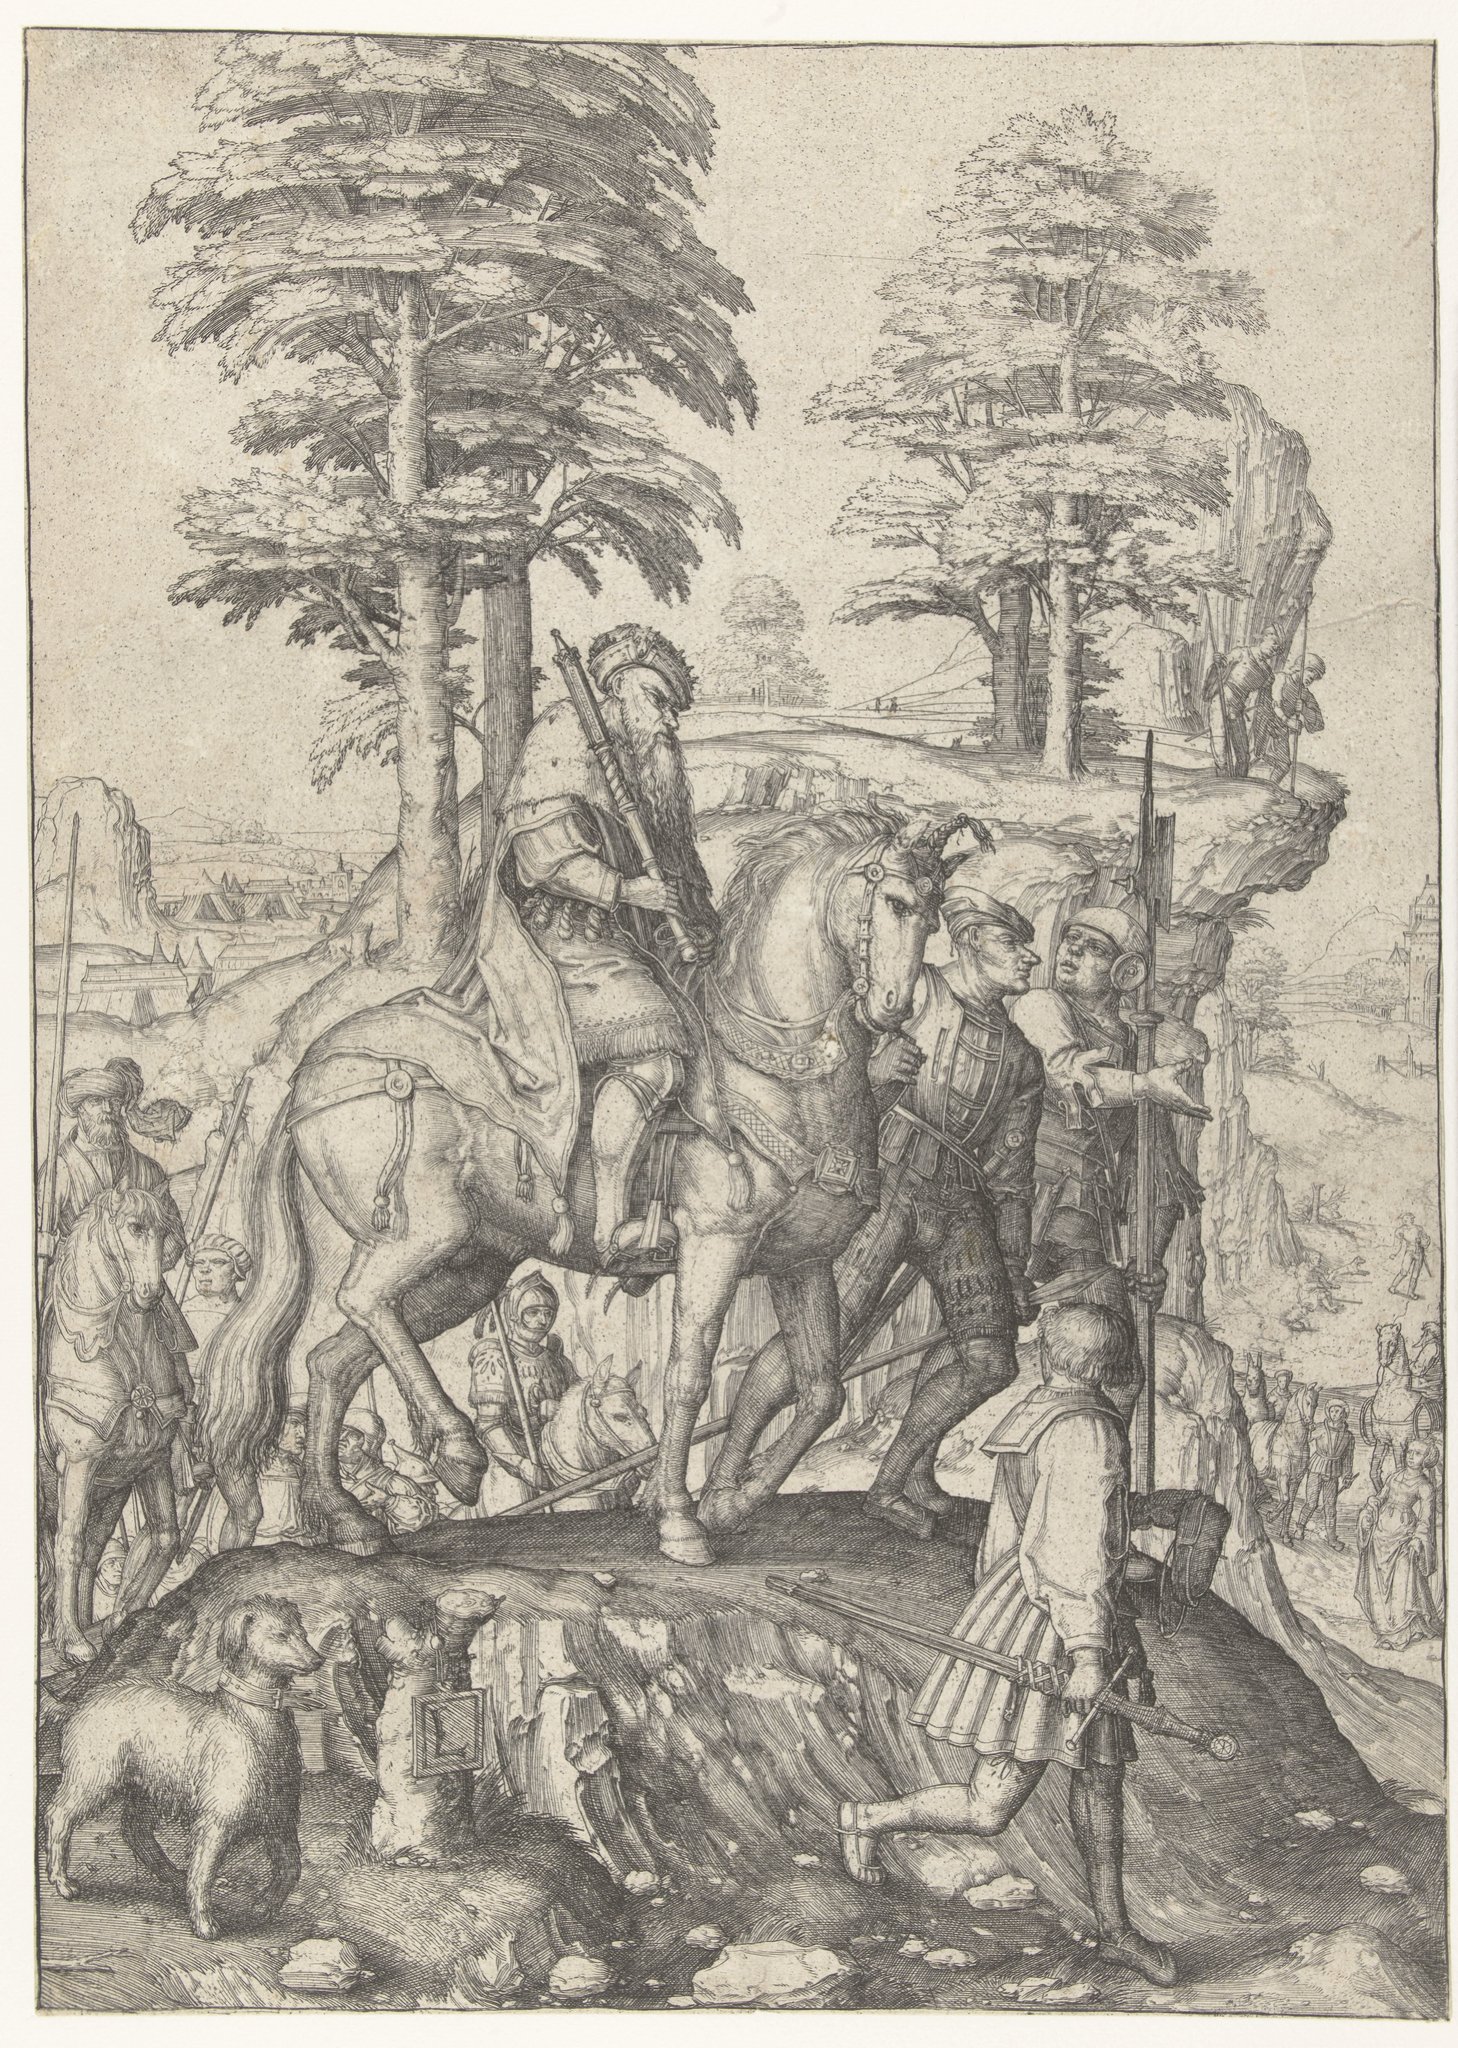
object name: print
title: David en Abigaïl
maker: lucas van leyden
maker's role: draughtsman, painter, print maker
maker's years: 1494-1533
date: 1505-1509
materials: paper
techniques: engraving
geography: low countries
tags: meeting of david and abigail, who kneels before him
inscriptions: collector's mark: Lugt 240, signature: ‘L’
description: Landschap met op de voorgrond David te paard met groep soldaten. In de verte Abigaïl te voet met lastdieren die voedsel dragen.